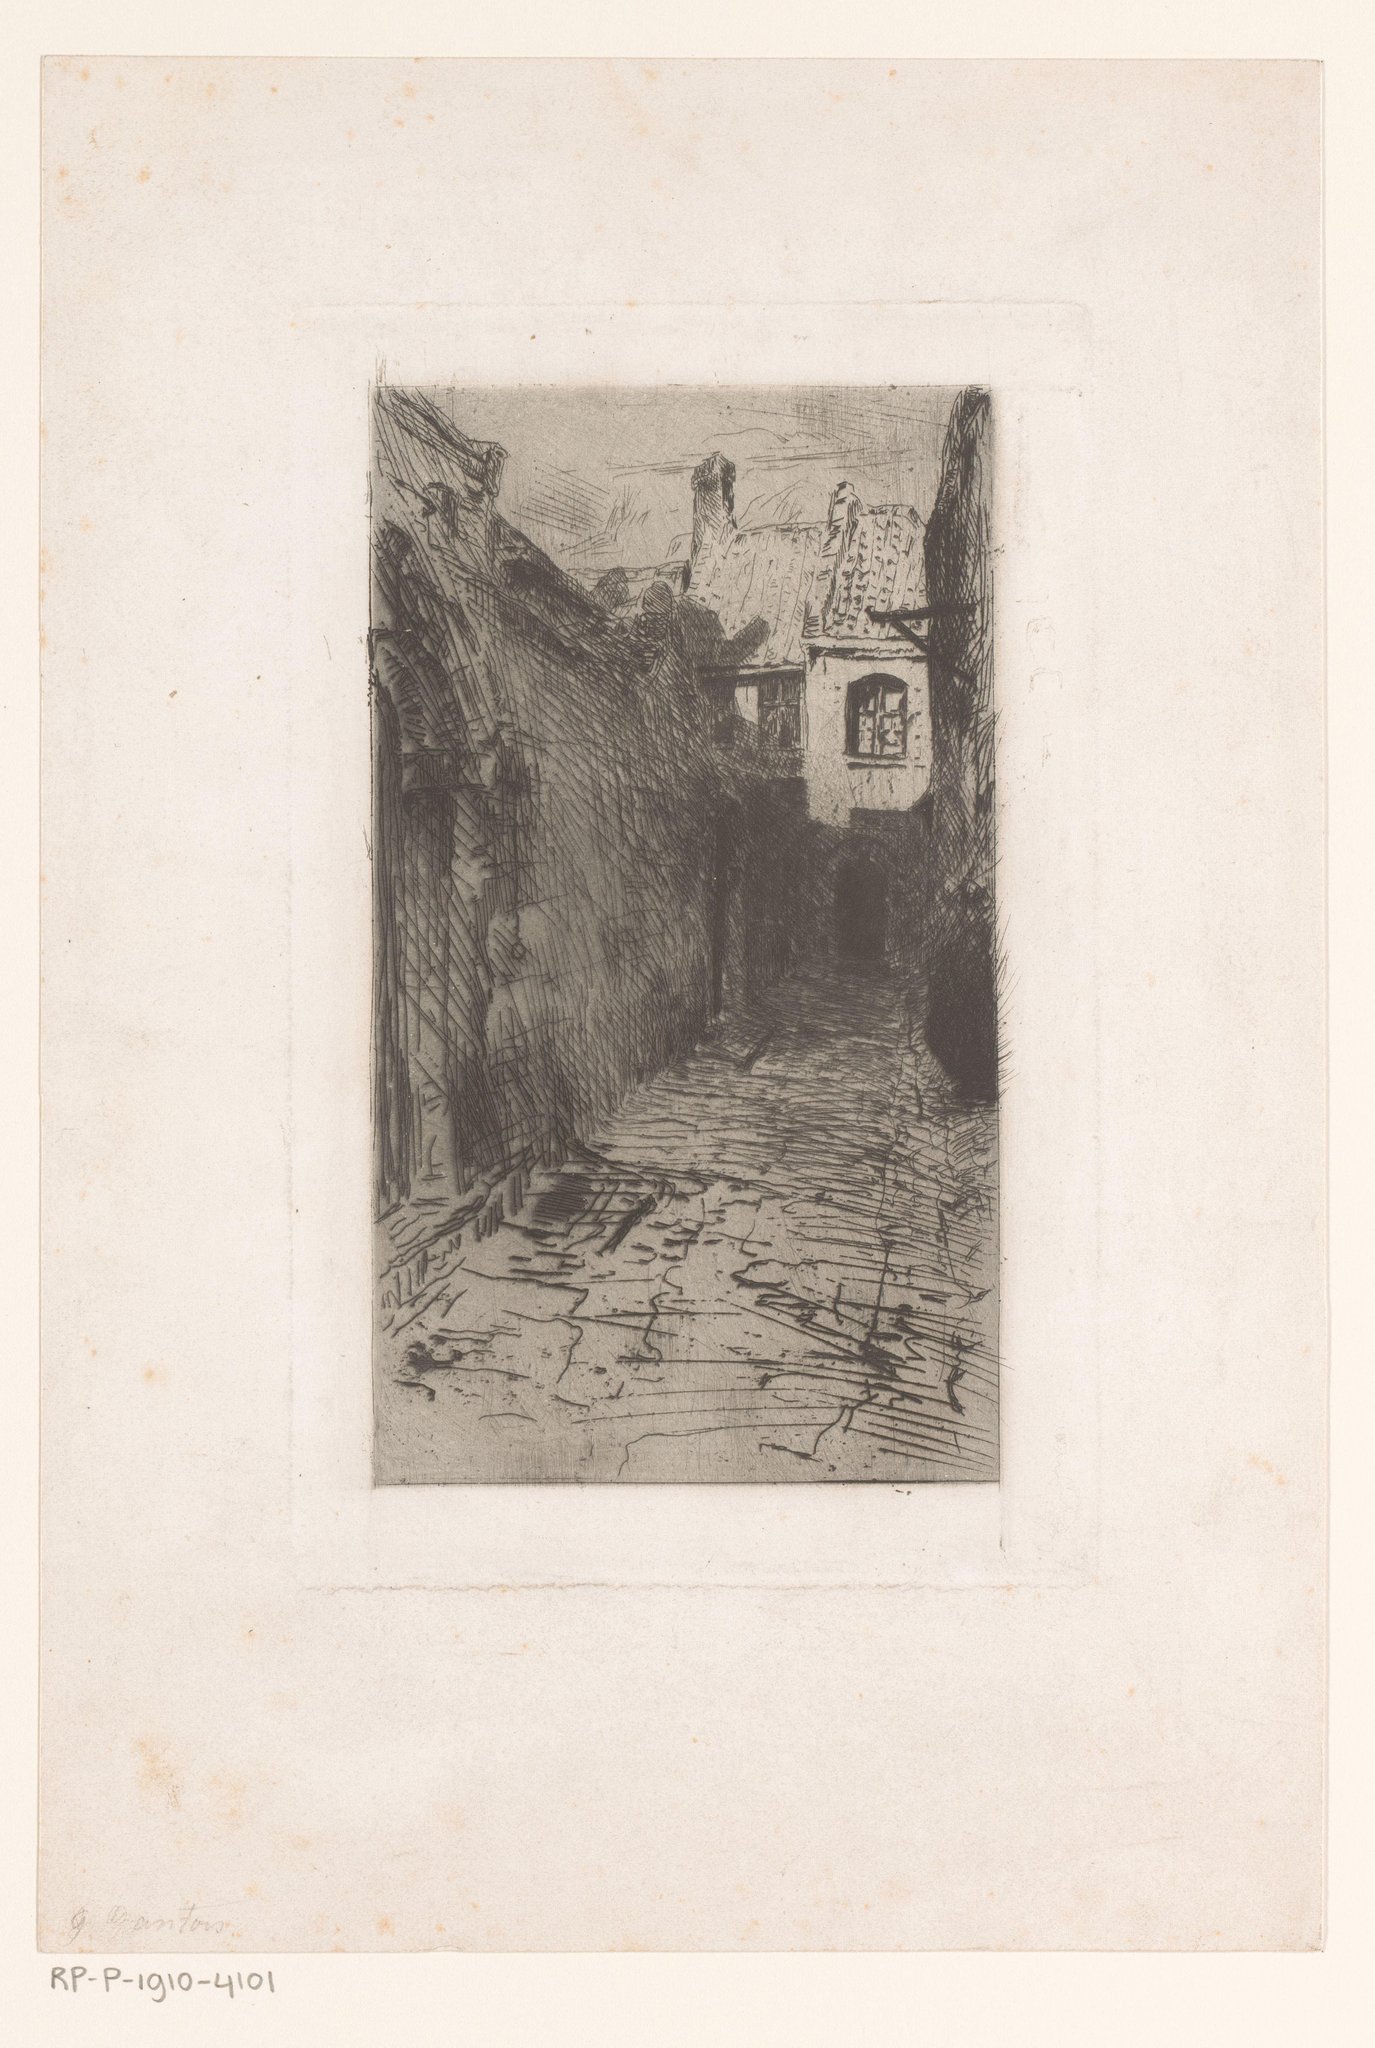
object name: print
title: Gezicht op een straat in Gent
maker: Anonymous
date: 1830-1910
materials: paper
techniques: etching, intaglio, retroussage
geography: belgium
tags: street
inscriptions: annotation: ‘9 gantois’, collector's mark: Lugt 2228